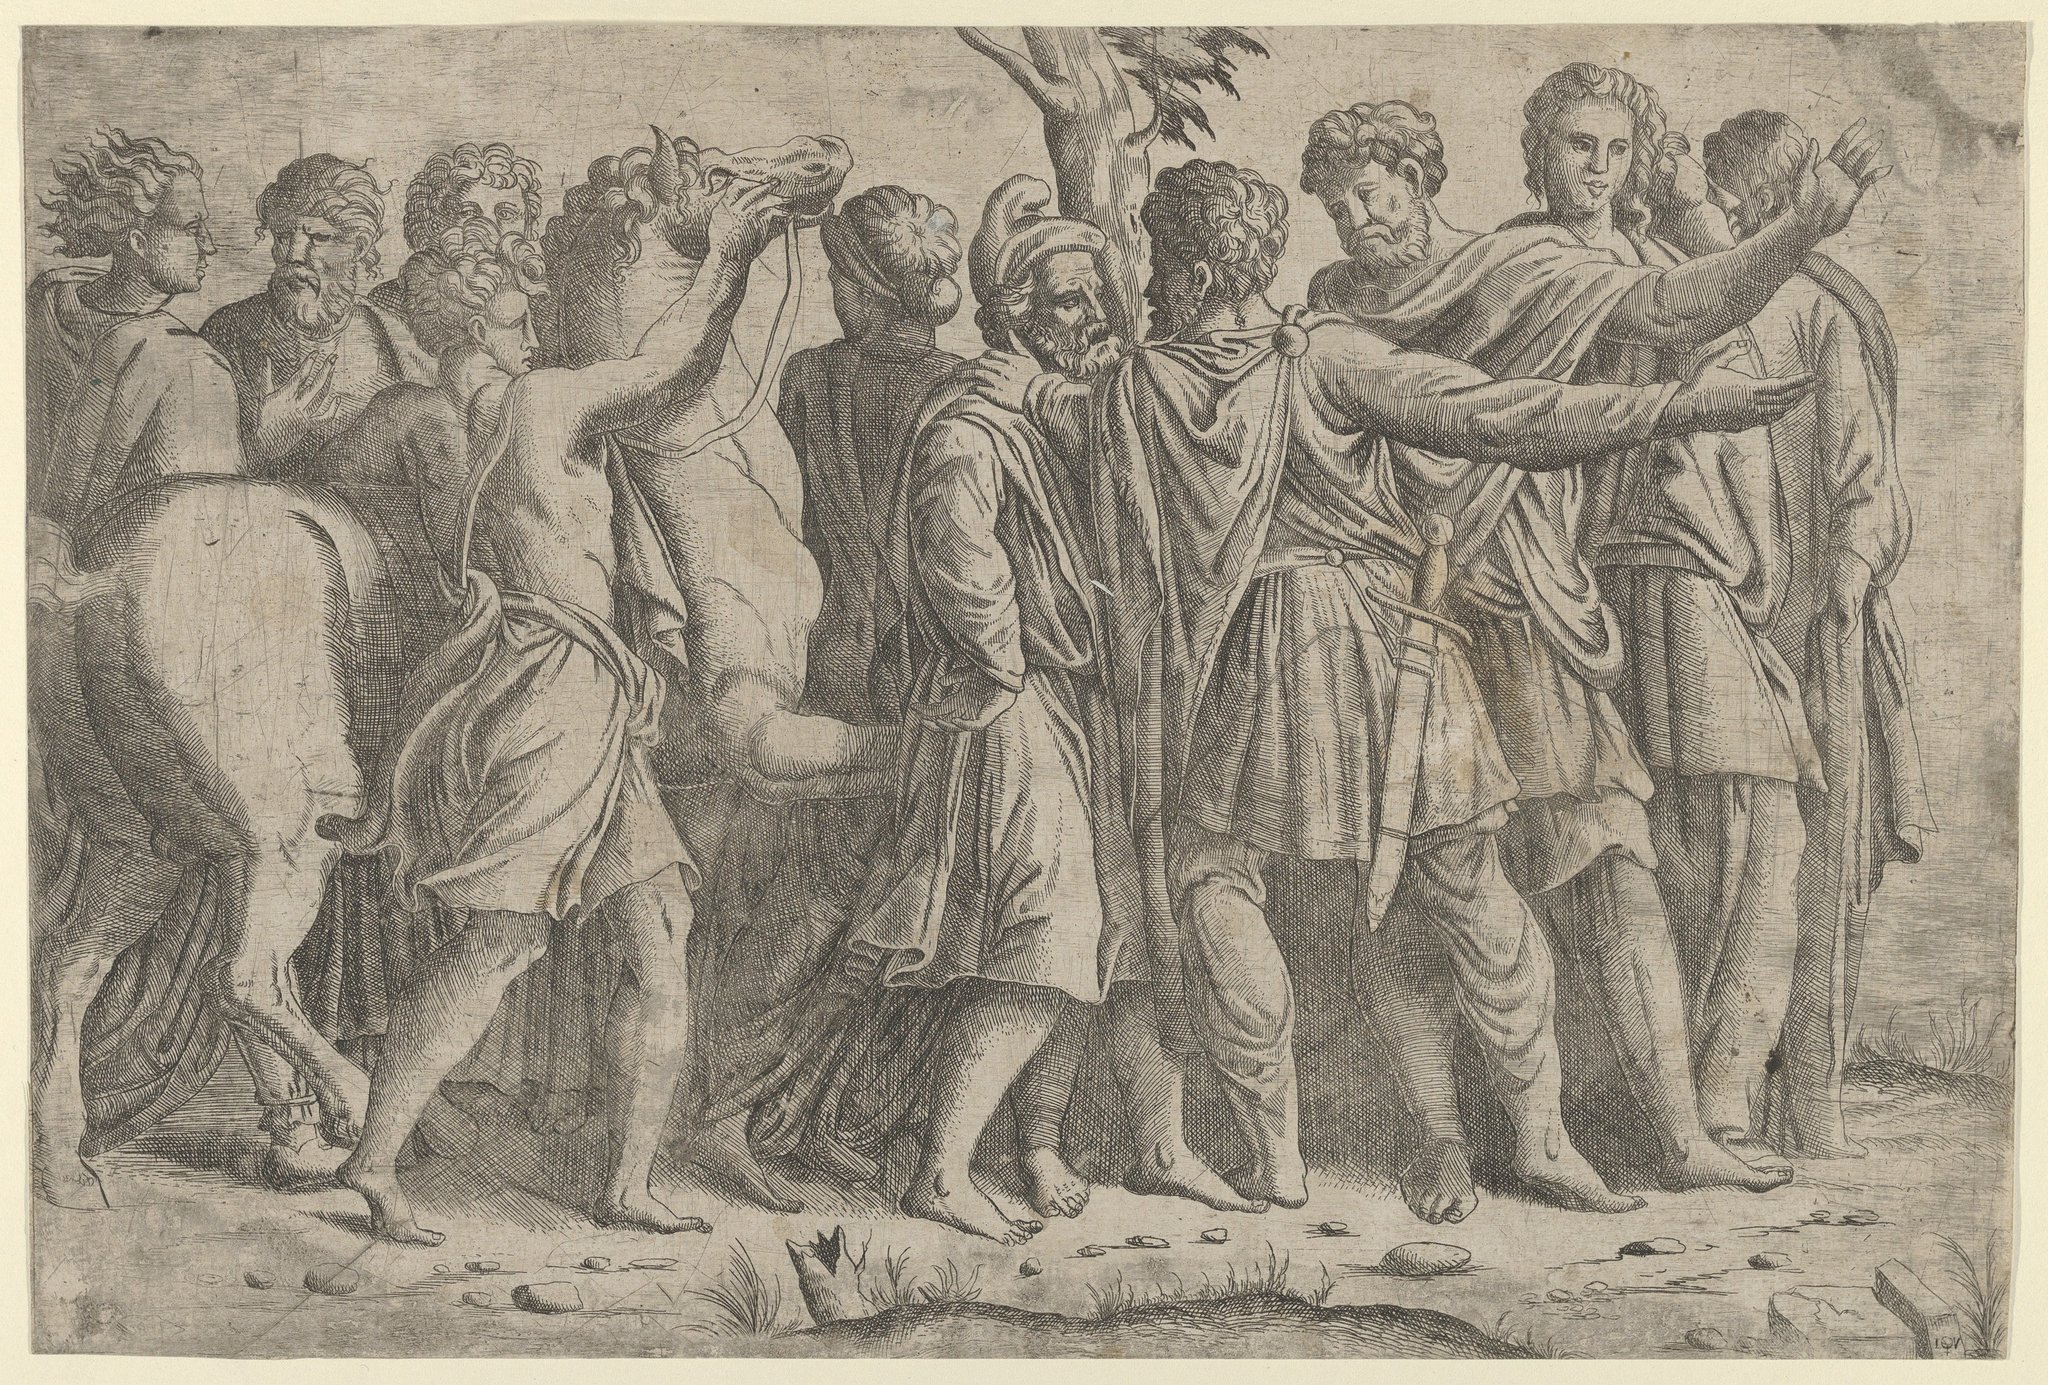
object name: print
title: Group of Roman Figures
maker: master iqv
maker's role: artist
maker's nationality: french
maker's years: 1500-1600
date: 1542-1545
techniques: etching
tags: men,horses